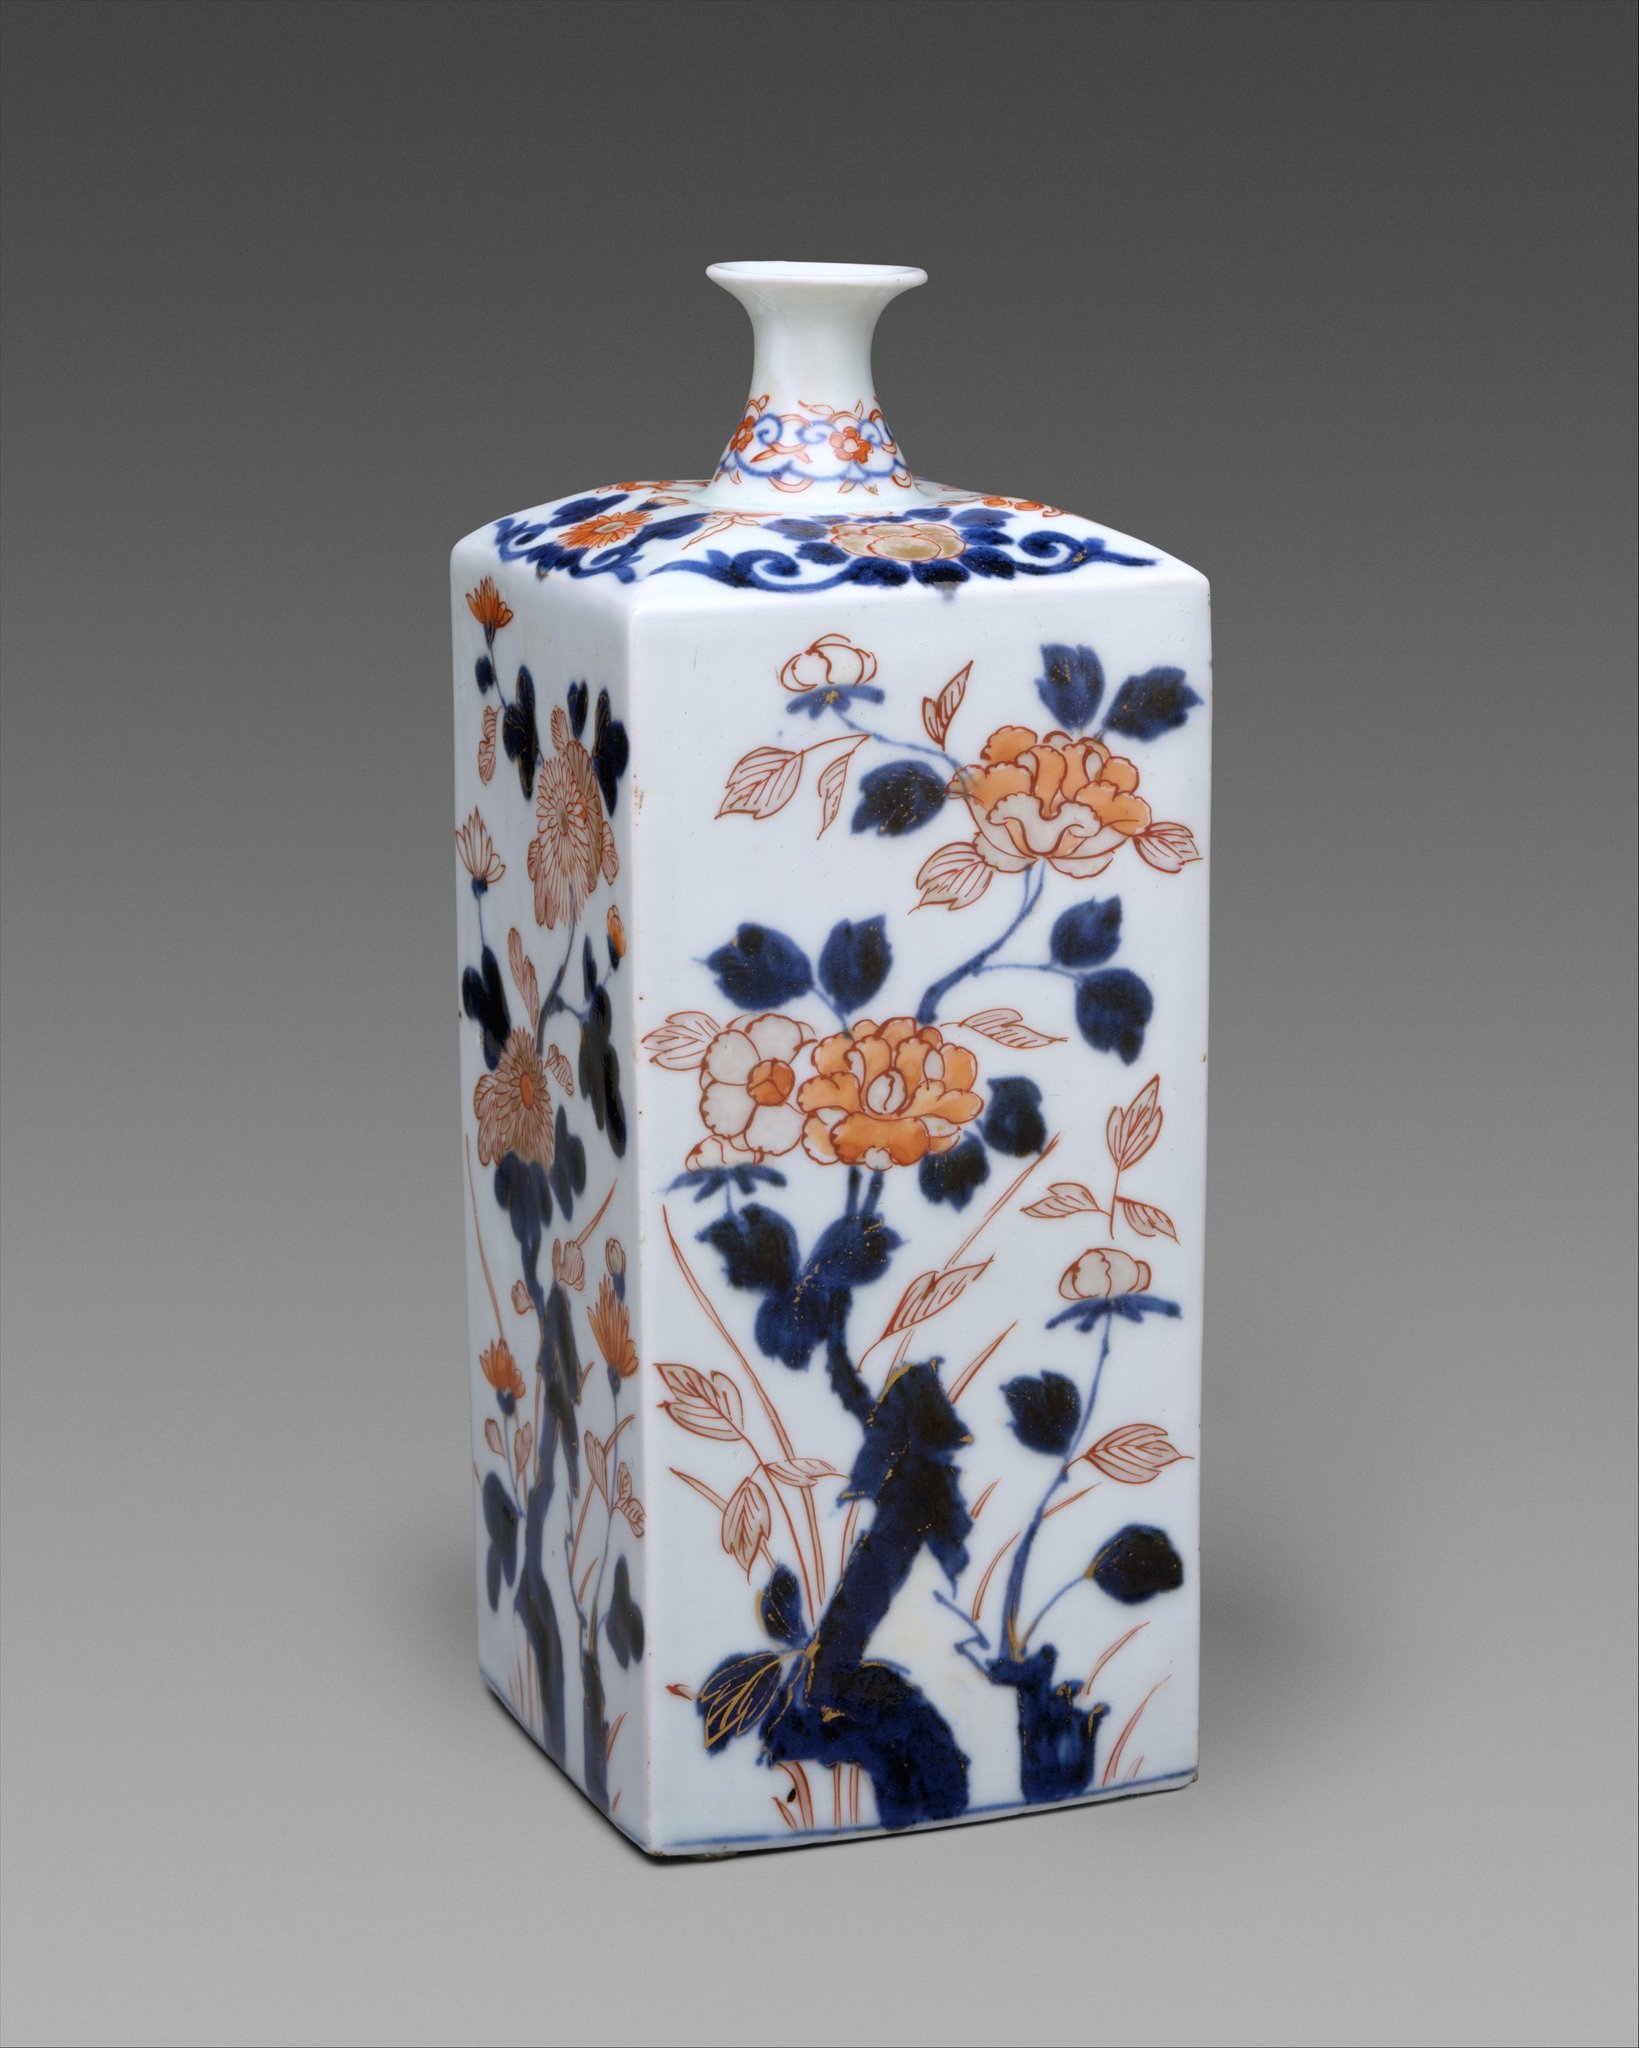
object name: bottle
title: Bottle with flowers of the four seasons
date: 1710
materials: enamel, glaze, hard paste porcelain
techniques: painting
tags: flowers